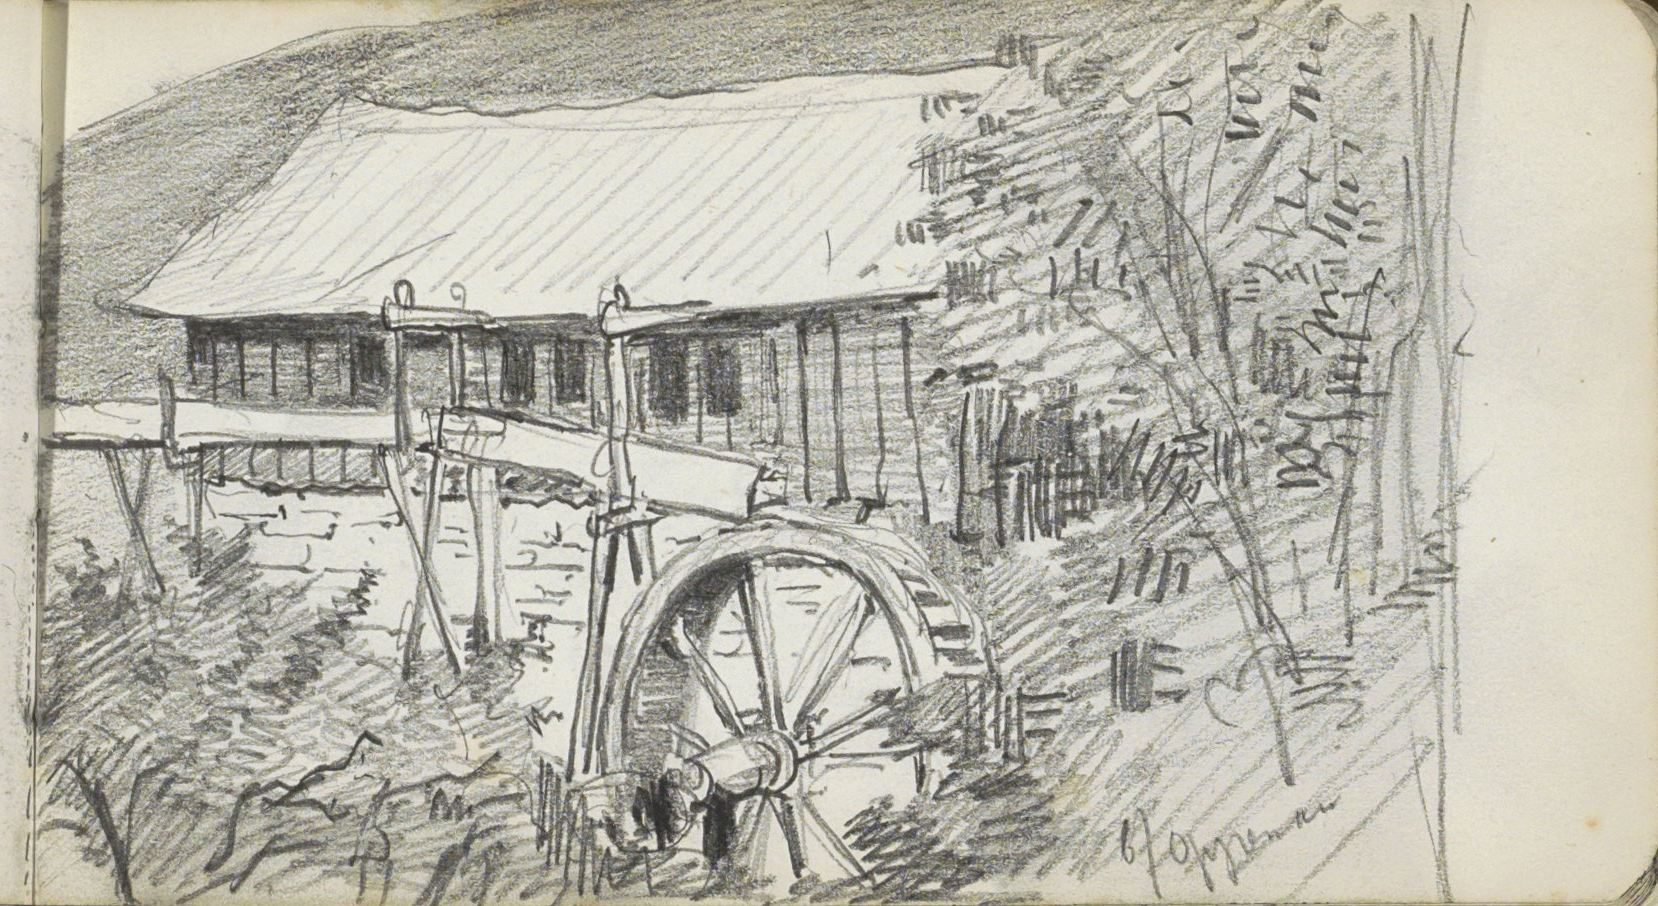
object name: sketchbook leaf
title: Watermolen te Oppenau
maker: geo poggenbeek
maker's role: draughtsman, painter, print maker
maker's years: 1853-1903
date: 1806-1876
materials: paper, pencil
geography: oppenau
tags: watermill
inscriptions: date and inscription: ‘6/Oppenau’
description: Blad 44 recto uit een schetsboek met 69 bladen.